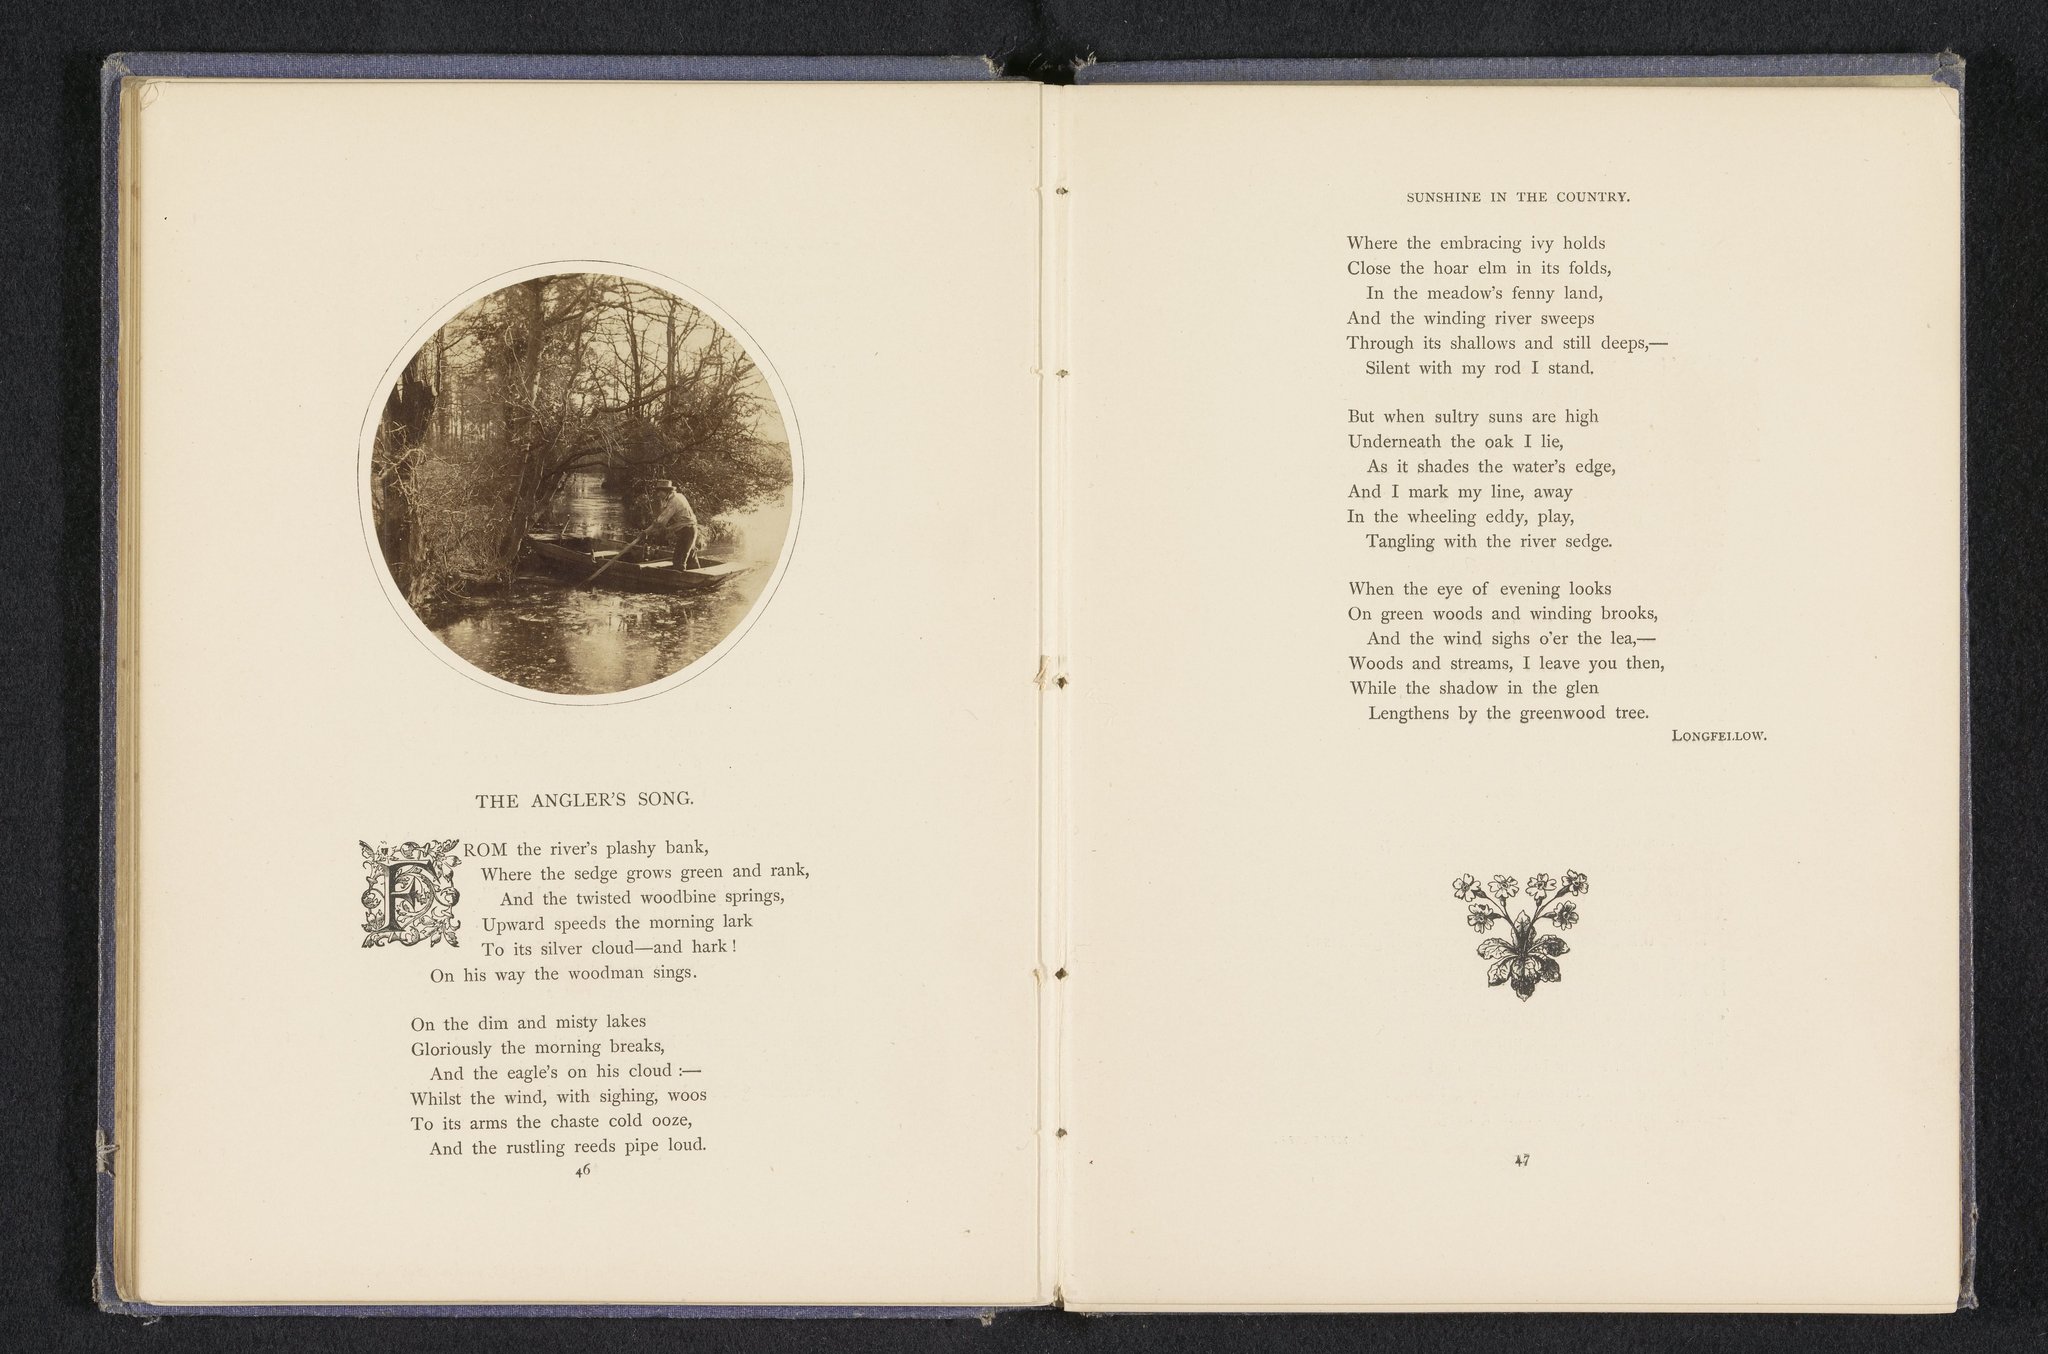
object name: page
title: Man op een roeiboot bij de oever van een meer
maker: william morris grundy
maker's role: fotograaf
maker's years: 1806-1859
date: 1851-1861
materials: photographic support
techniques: albumen print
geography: sutton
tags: boat propelled by man or animal